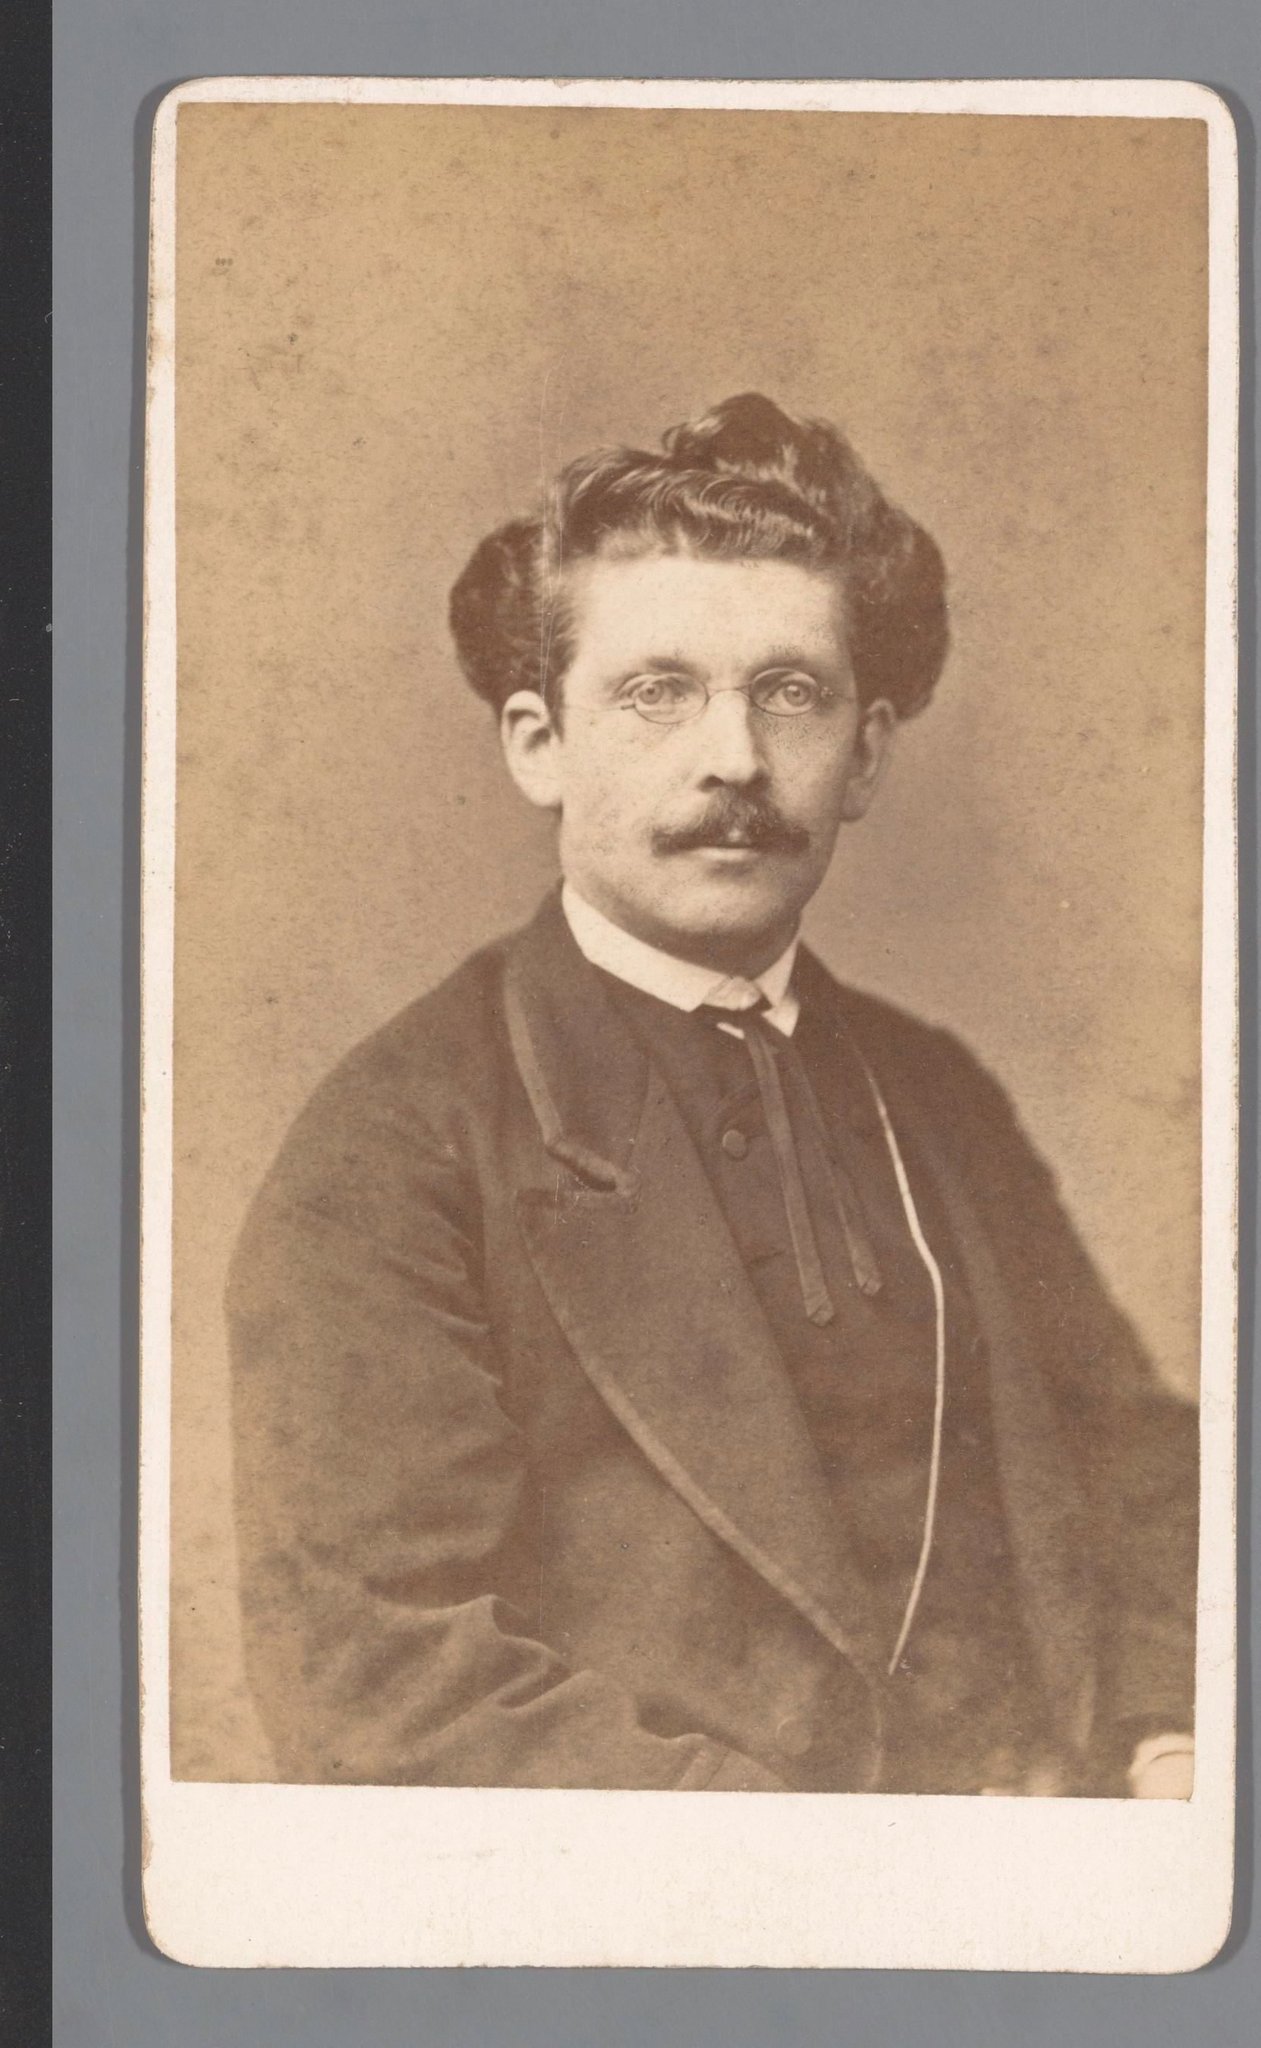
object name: photograph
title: Portret van Adrien Wagemakers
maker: eduard fuchs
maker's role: painter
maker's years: 1832-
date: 1859-1870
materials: cardboard, photographic support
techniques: albumen print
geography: leeuwarden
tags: historical persons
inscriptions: name: ‘Adrien/ Wagemakers.’